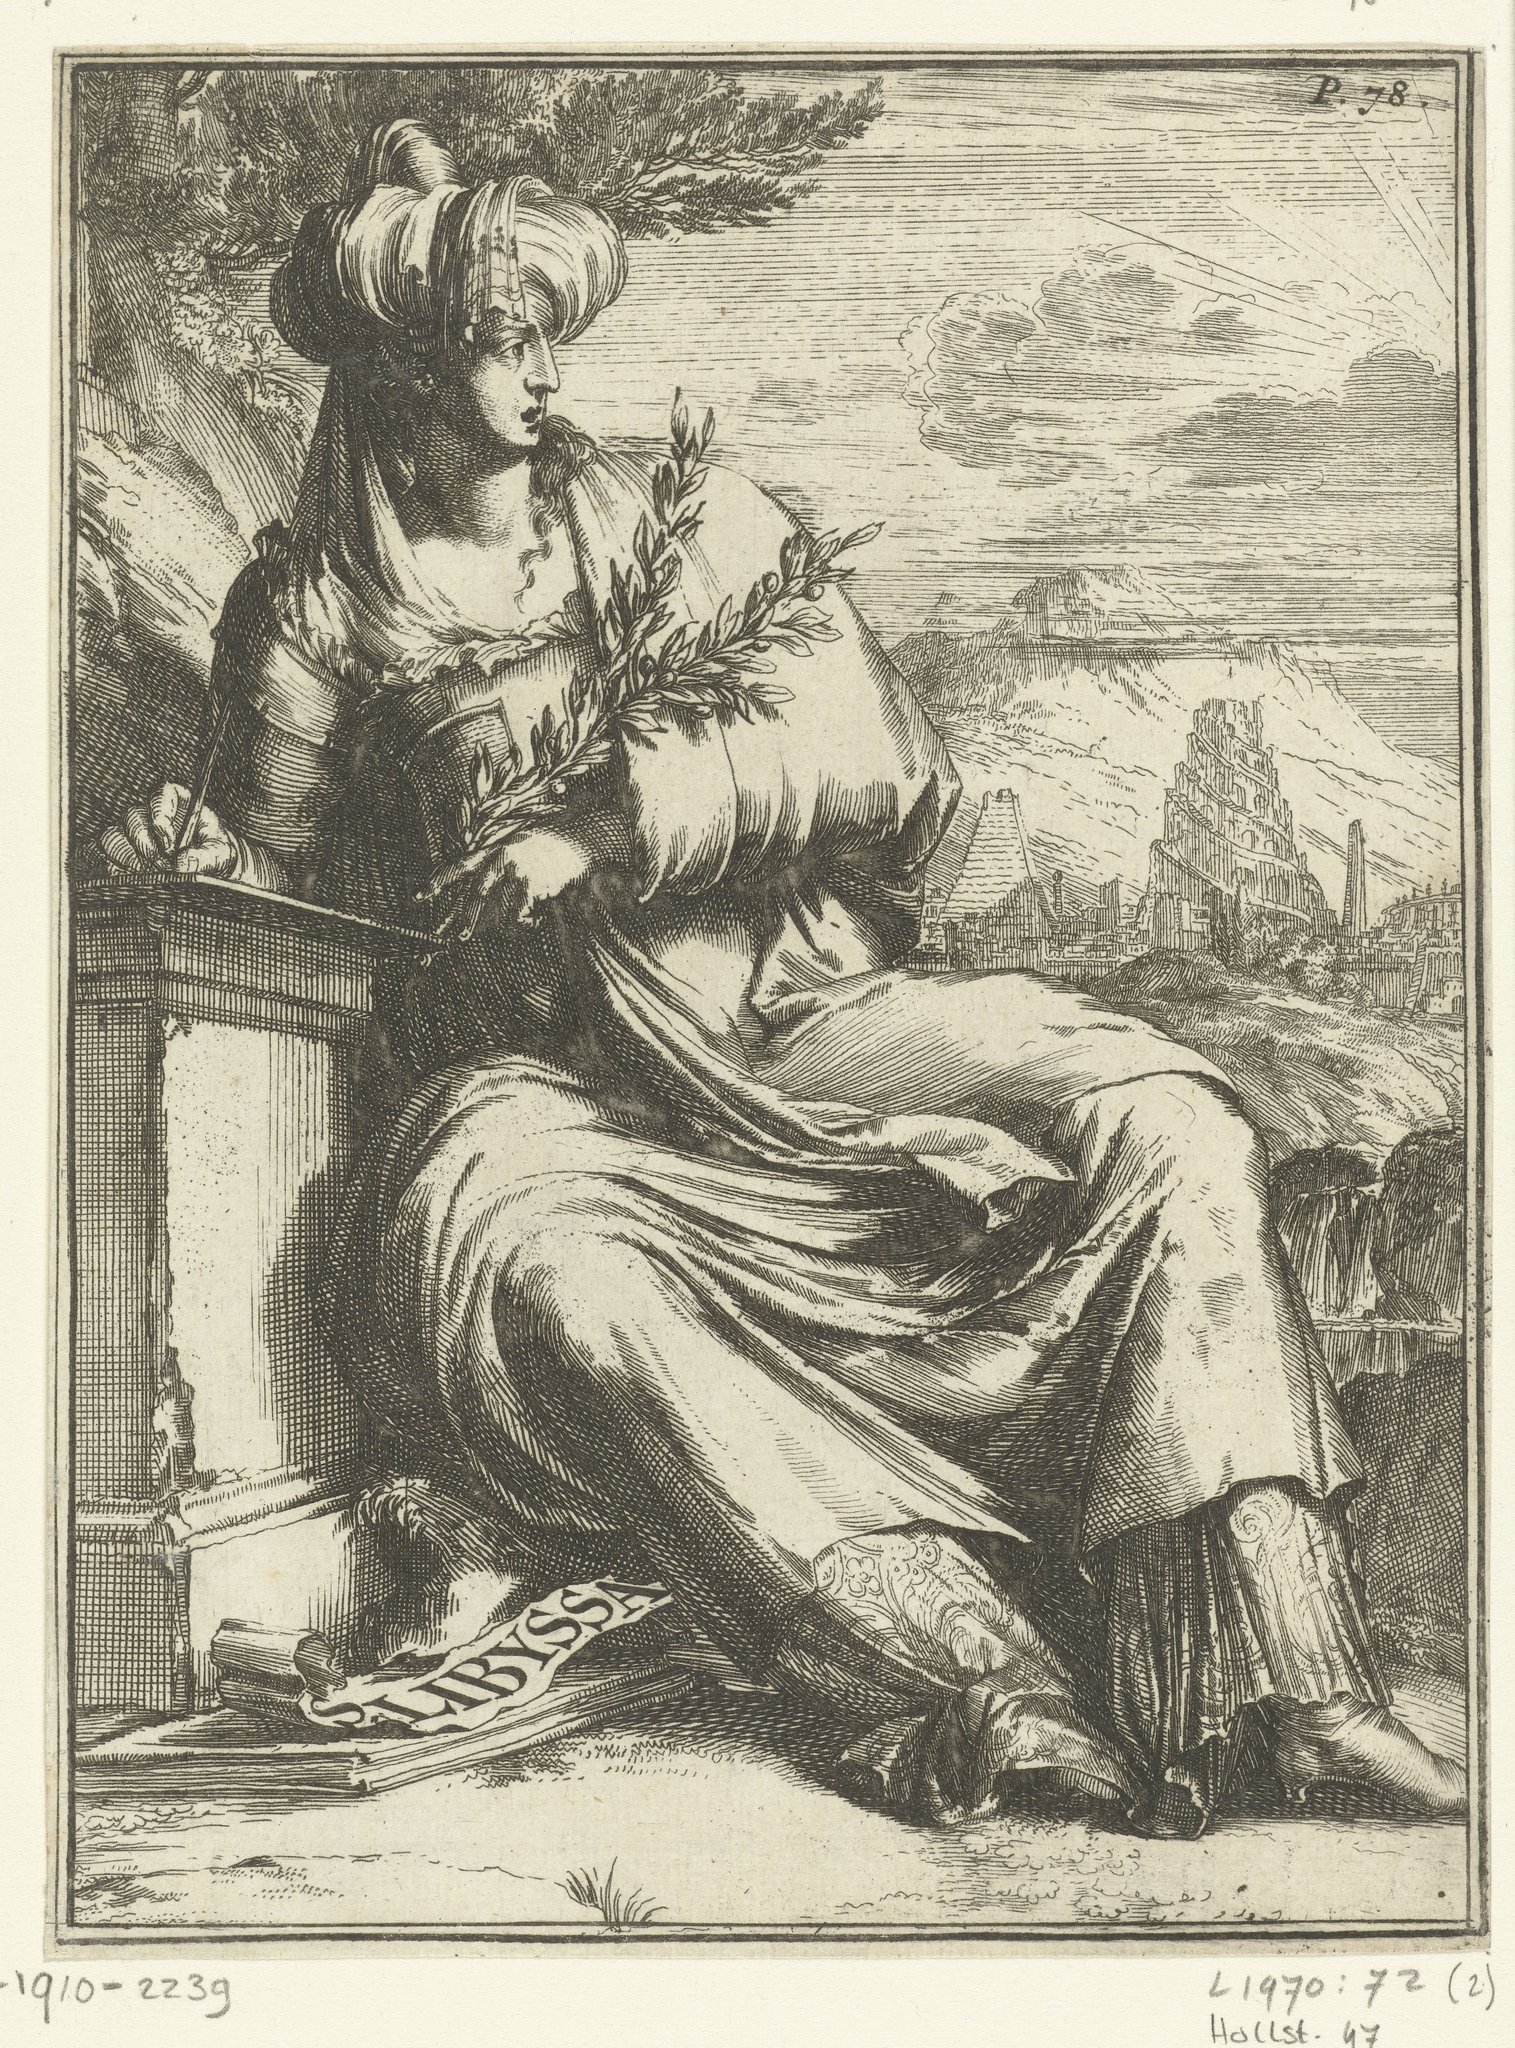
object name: book illustration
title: S. Libyssa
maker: romeyn de hooghe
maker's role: draughtsman, goldsmith, painter, print maker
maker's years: 1645-1708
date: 1688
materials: paper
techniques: engraving, etching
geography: netherlands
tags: sibyls (with name)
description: Illustratie voor: Servatius Gallaeus, Dissertationes de Sibyllis, earumque oraculis, Amsterdam, Dirk en Hendrik Boom, 1688, p. 78.